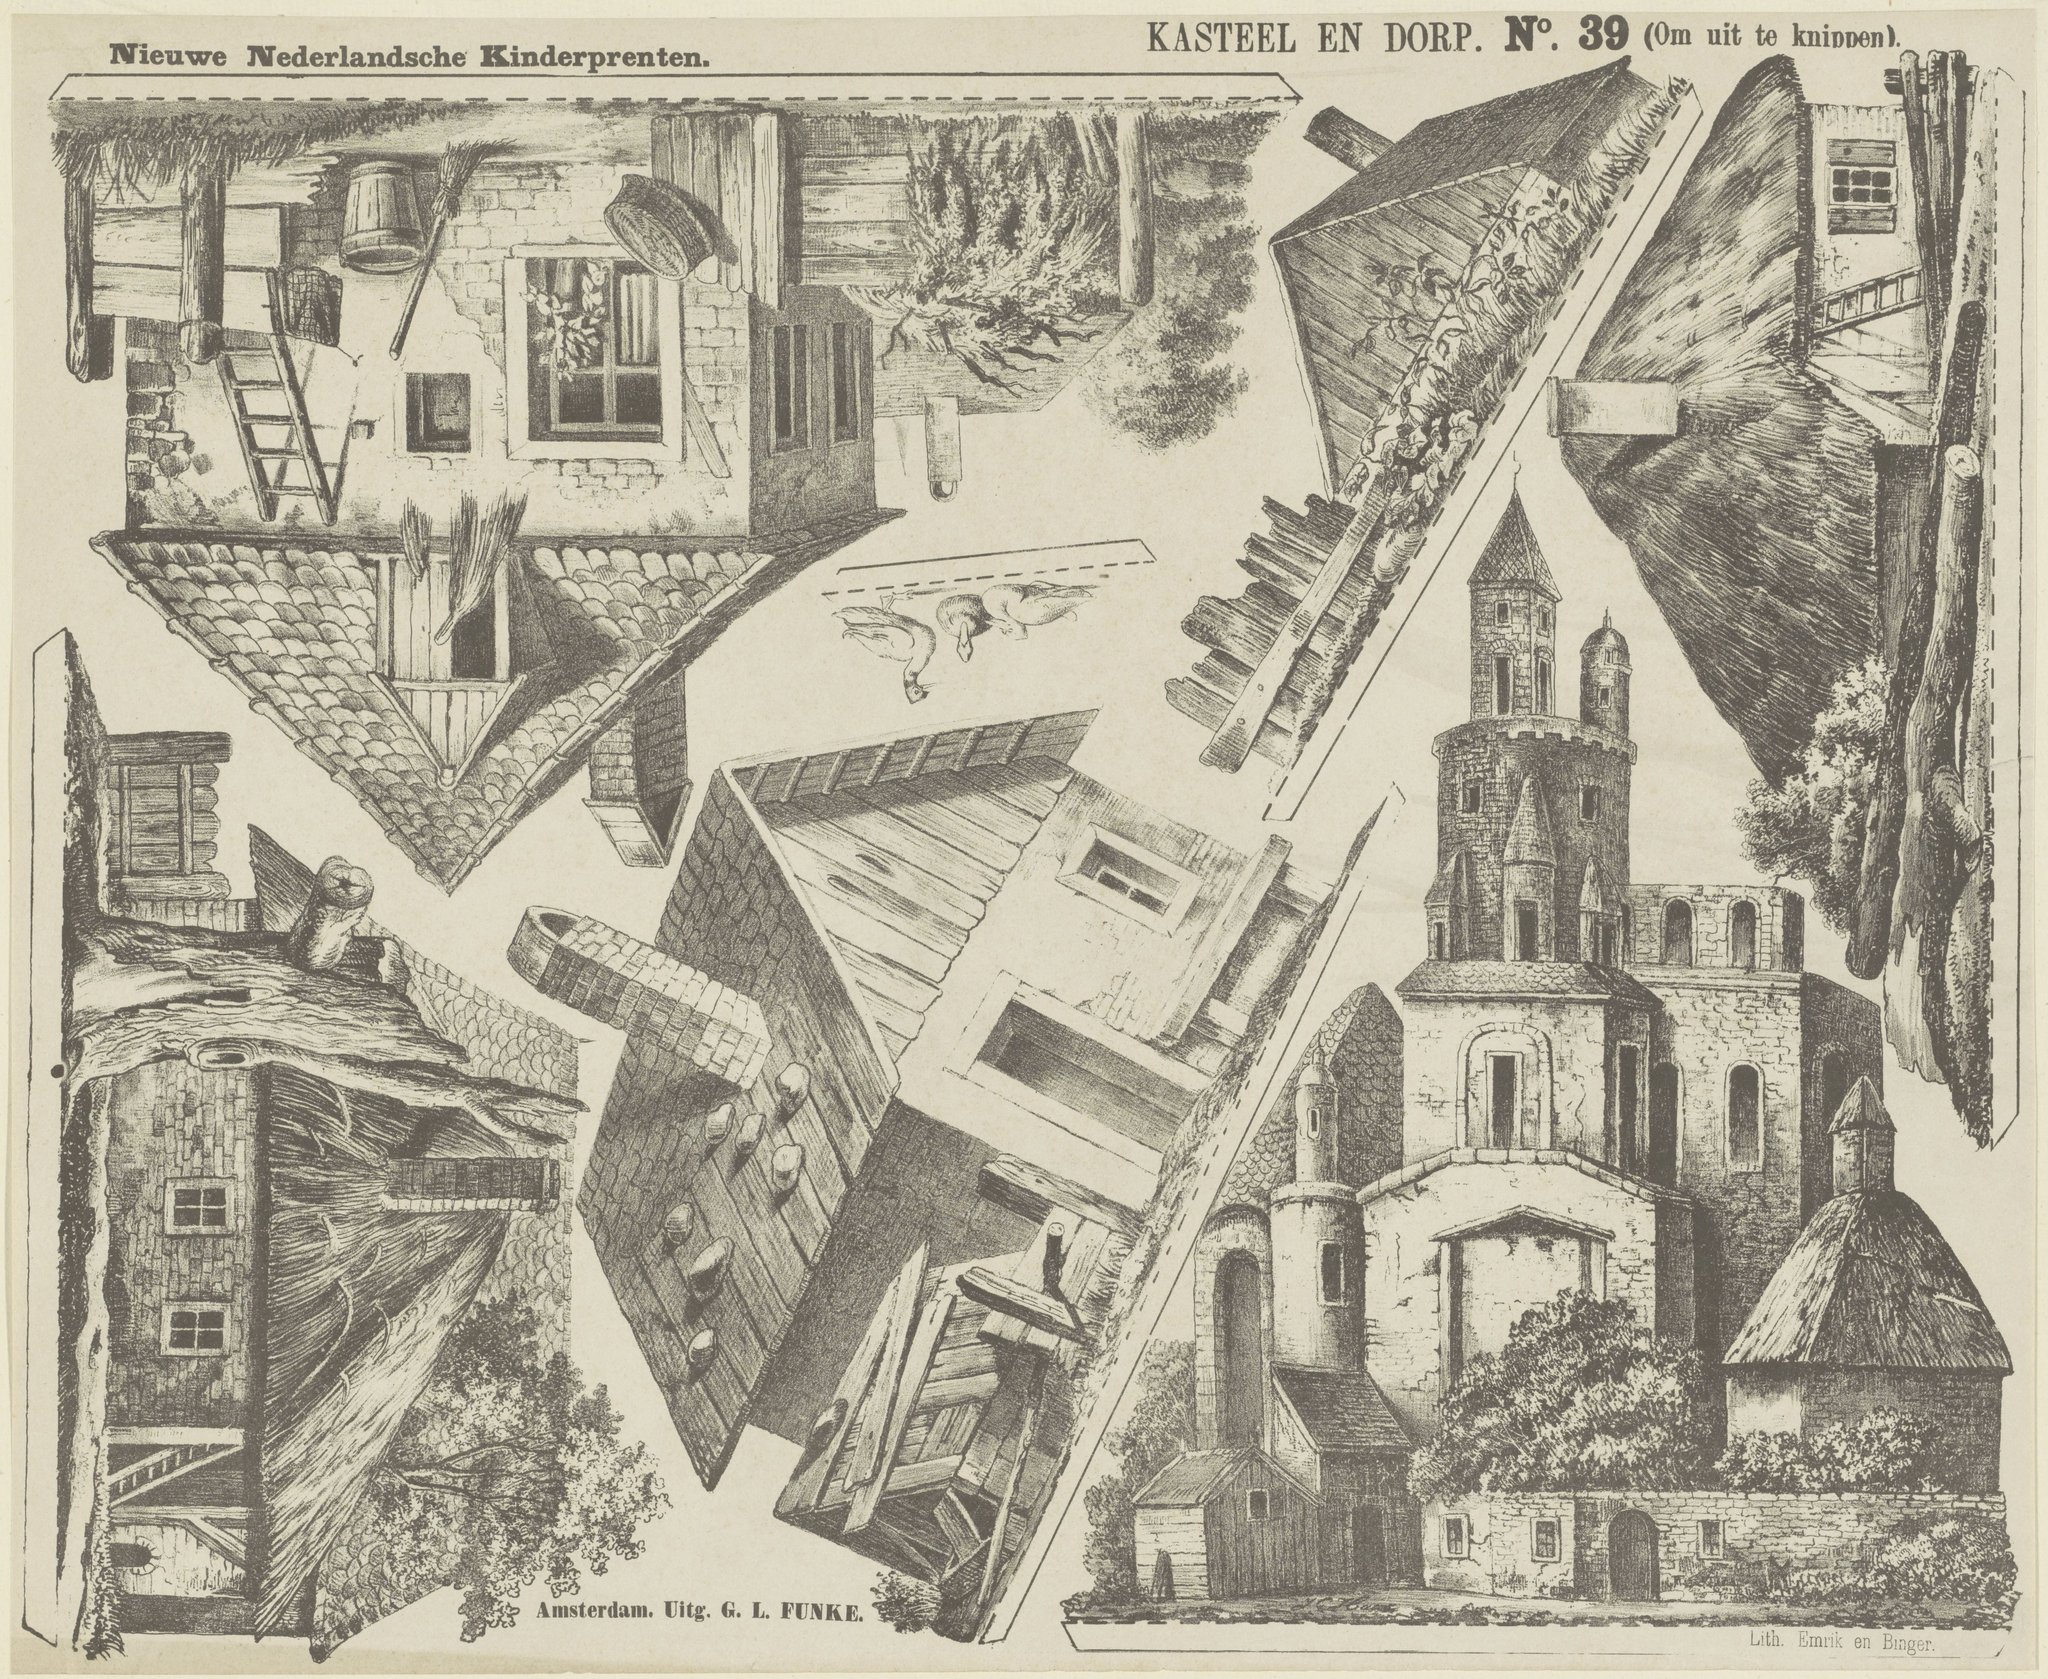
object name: print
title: Nieuwe Nederlandsche kinderprenten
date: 1865-1875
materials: paper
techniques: letterpress printing, lithograph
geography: haarlem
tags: water-birds: goose, castle, farm (building)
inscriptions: collector's mark: Lugt 2760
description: Blad met 7 voorstellingen van een kasteel, boerderijen en ganzen om uit te knippen. Genummerd rechtsboven: No. 39.